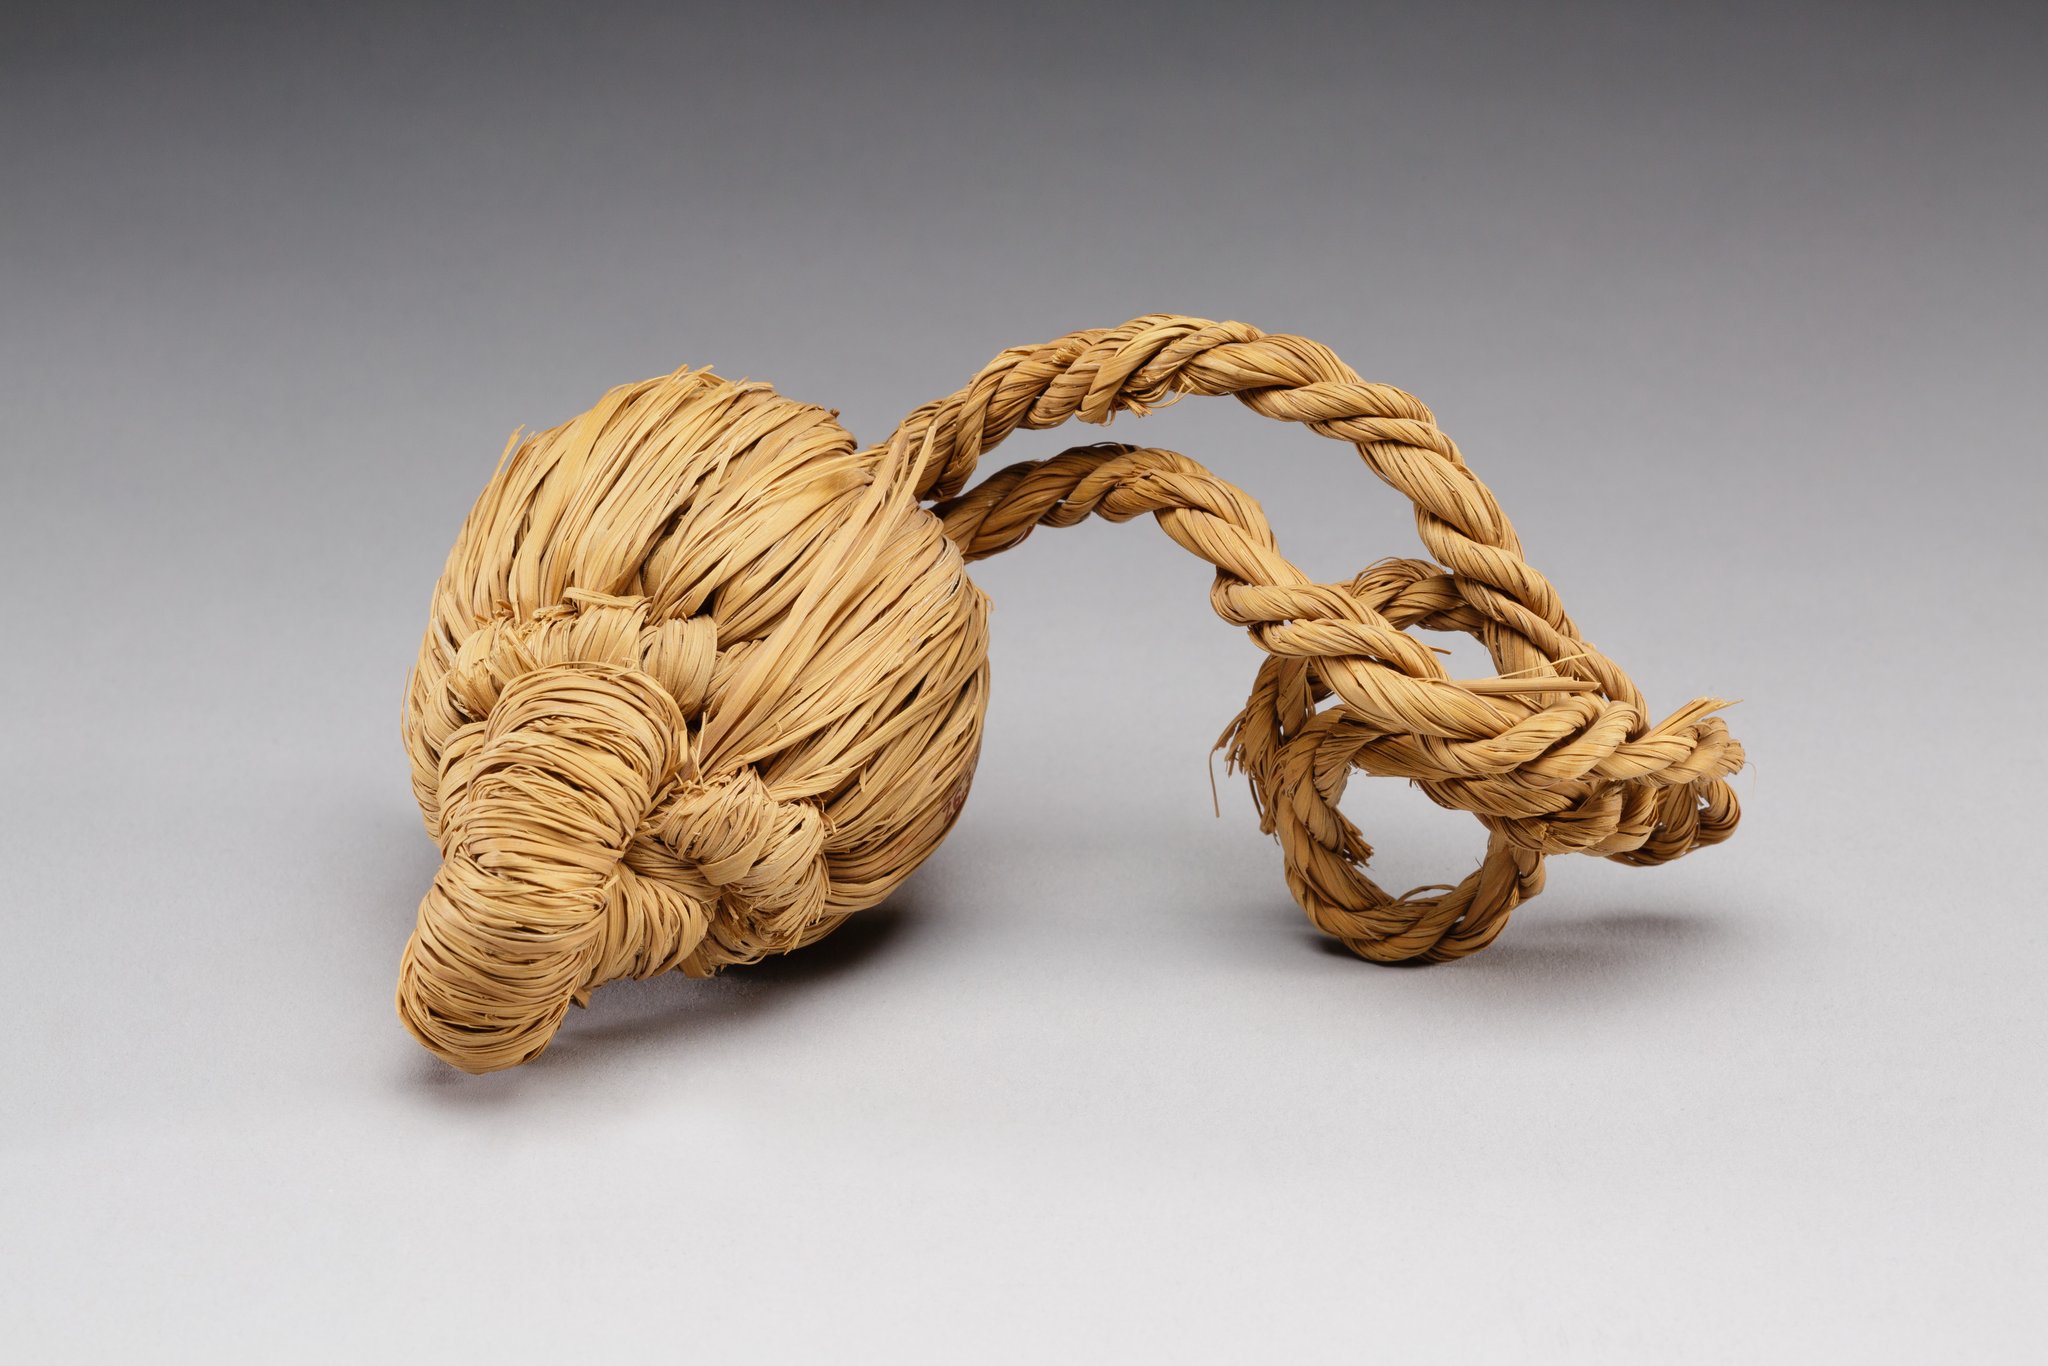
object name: rope attachment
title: Jar Stopper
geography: egypt